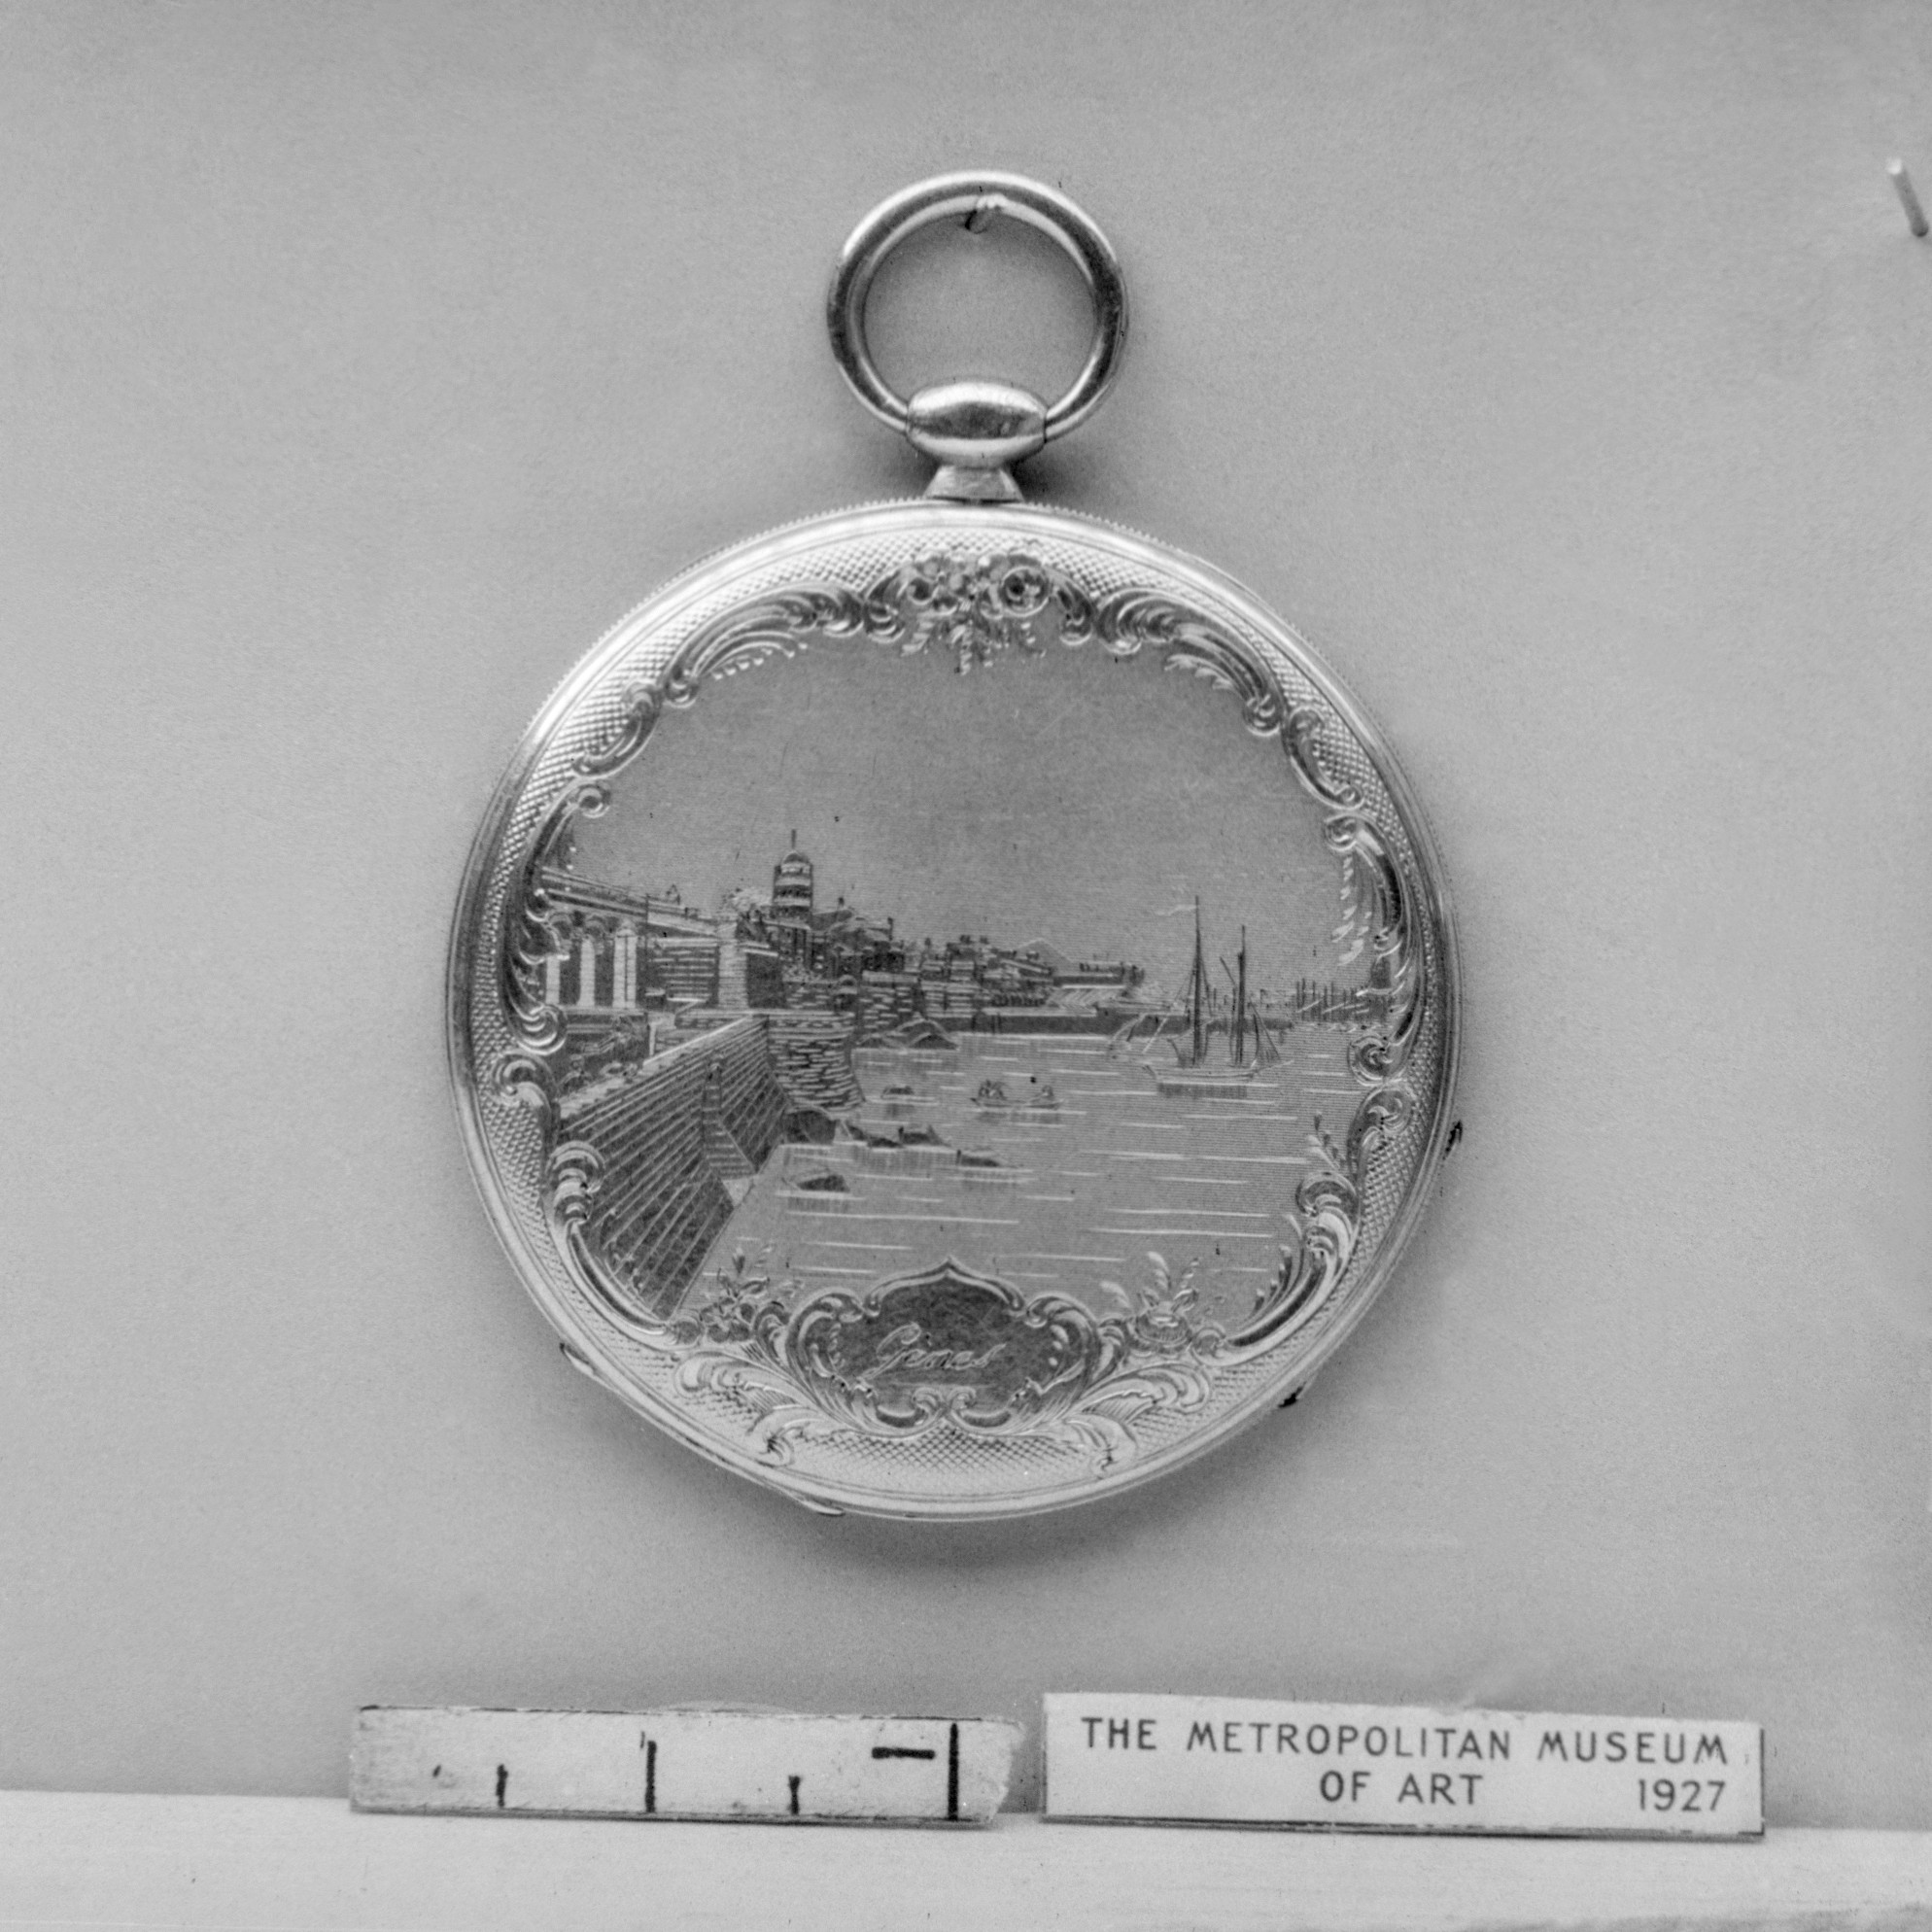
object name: watch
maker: firm of alliez and berguer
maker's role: maker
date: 1834-1866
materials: enamel, gold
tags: buildings,boats